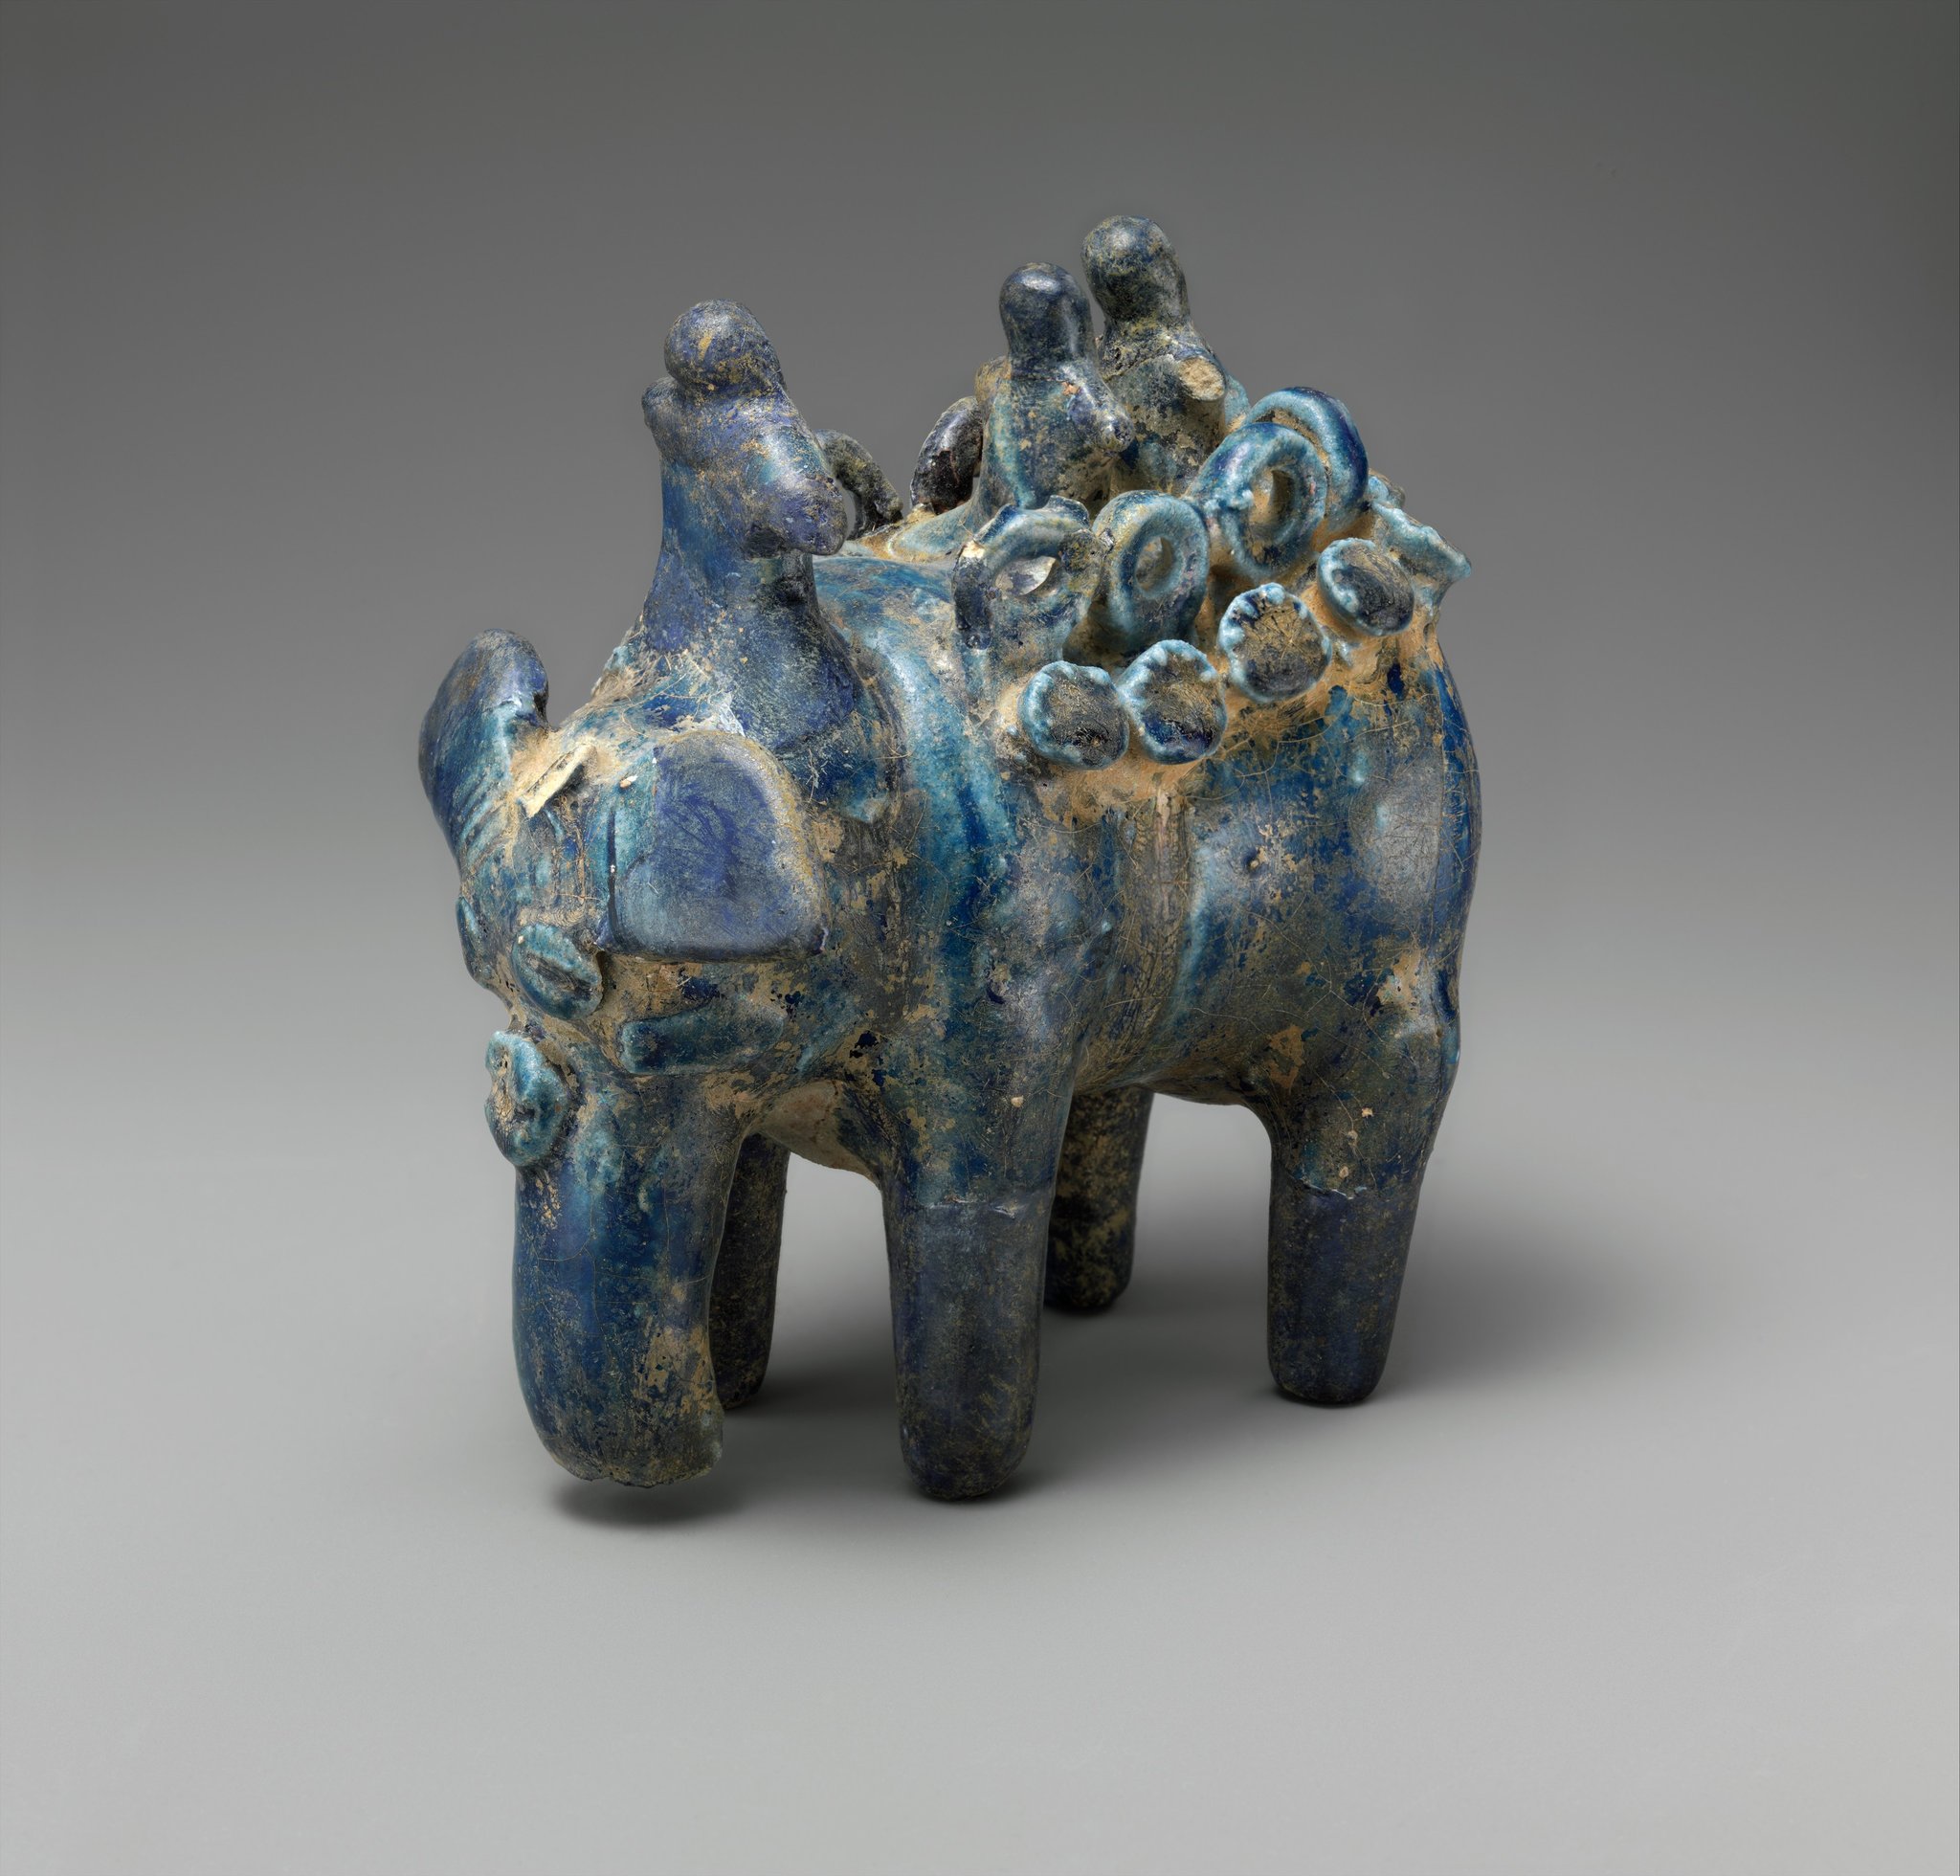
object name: figure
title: Elephant Carrying Two Figures Seated on Hawda and Mahout Seated on Neck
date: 1067-1200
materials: glaze, stonepaste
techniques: molding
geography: iran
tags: human figures,elephants